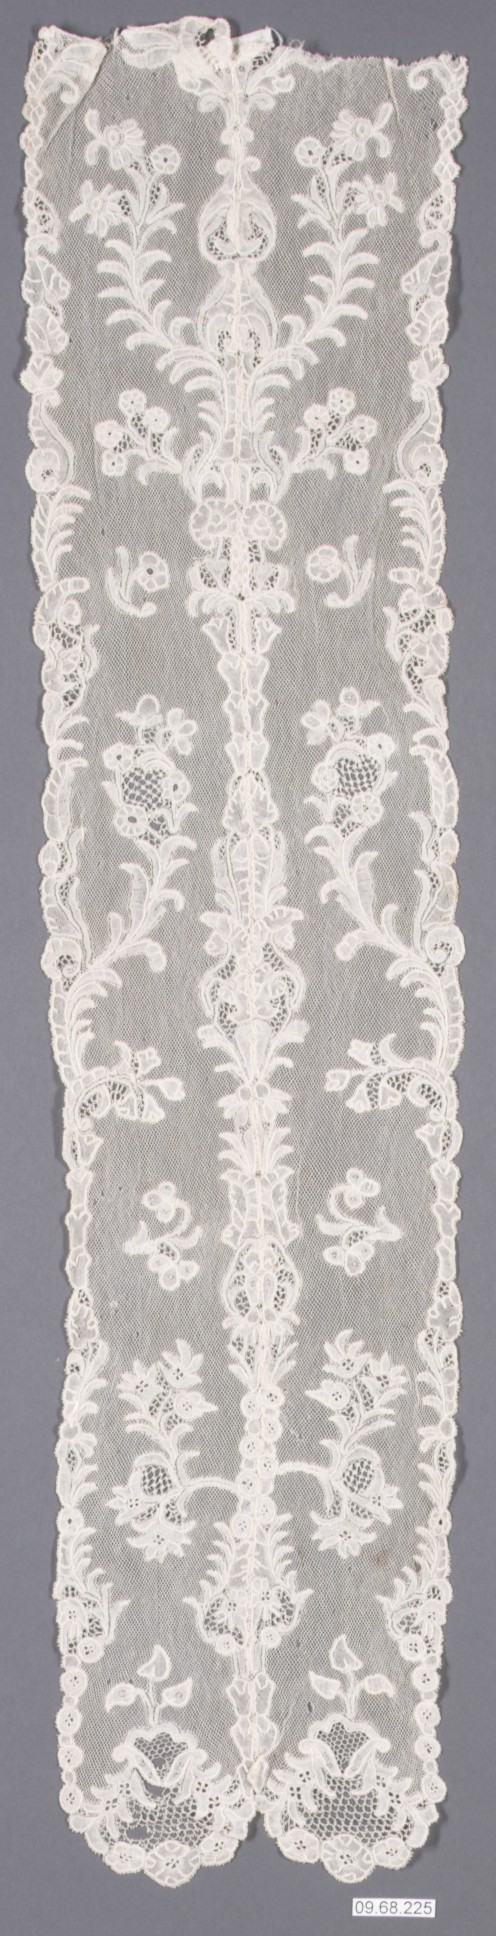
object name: lappet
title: Lappets (2)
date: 1701-1800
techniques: lace